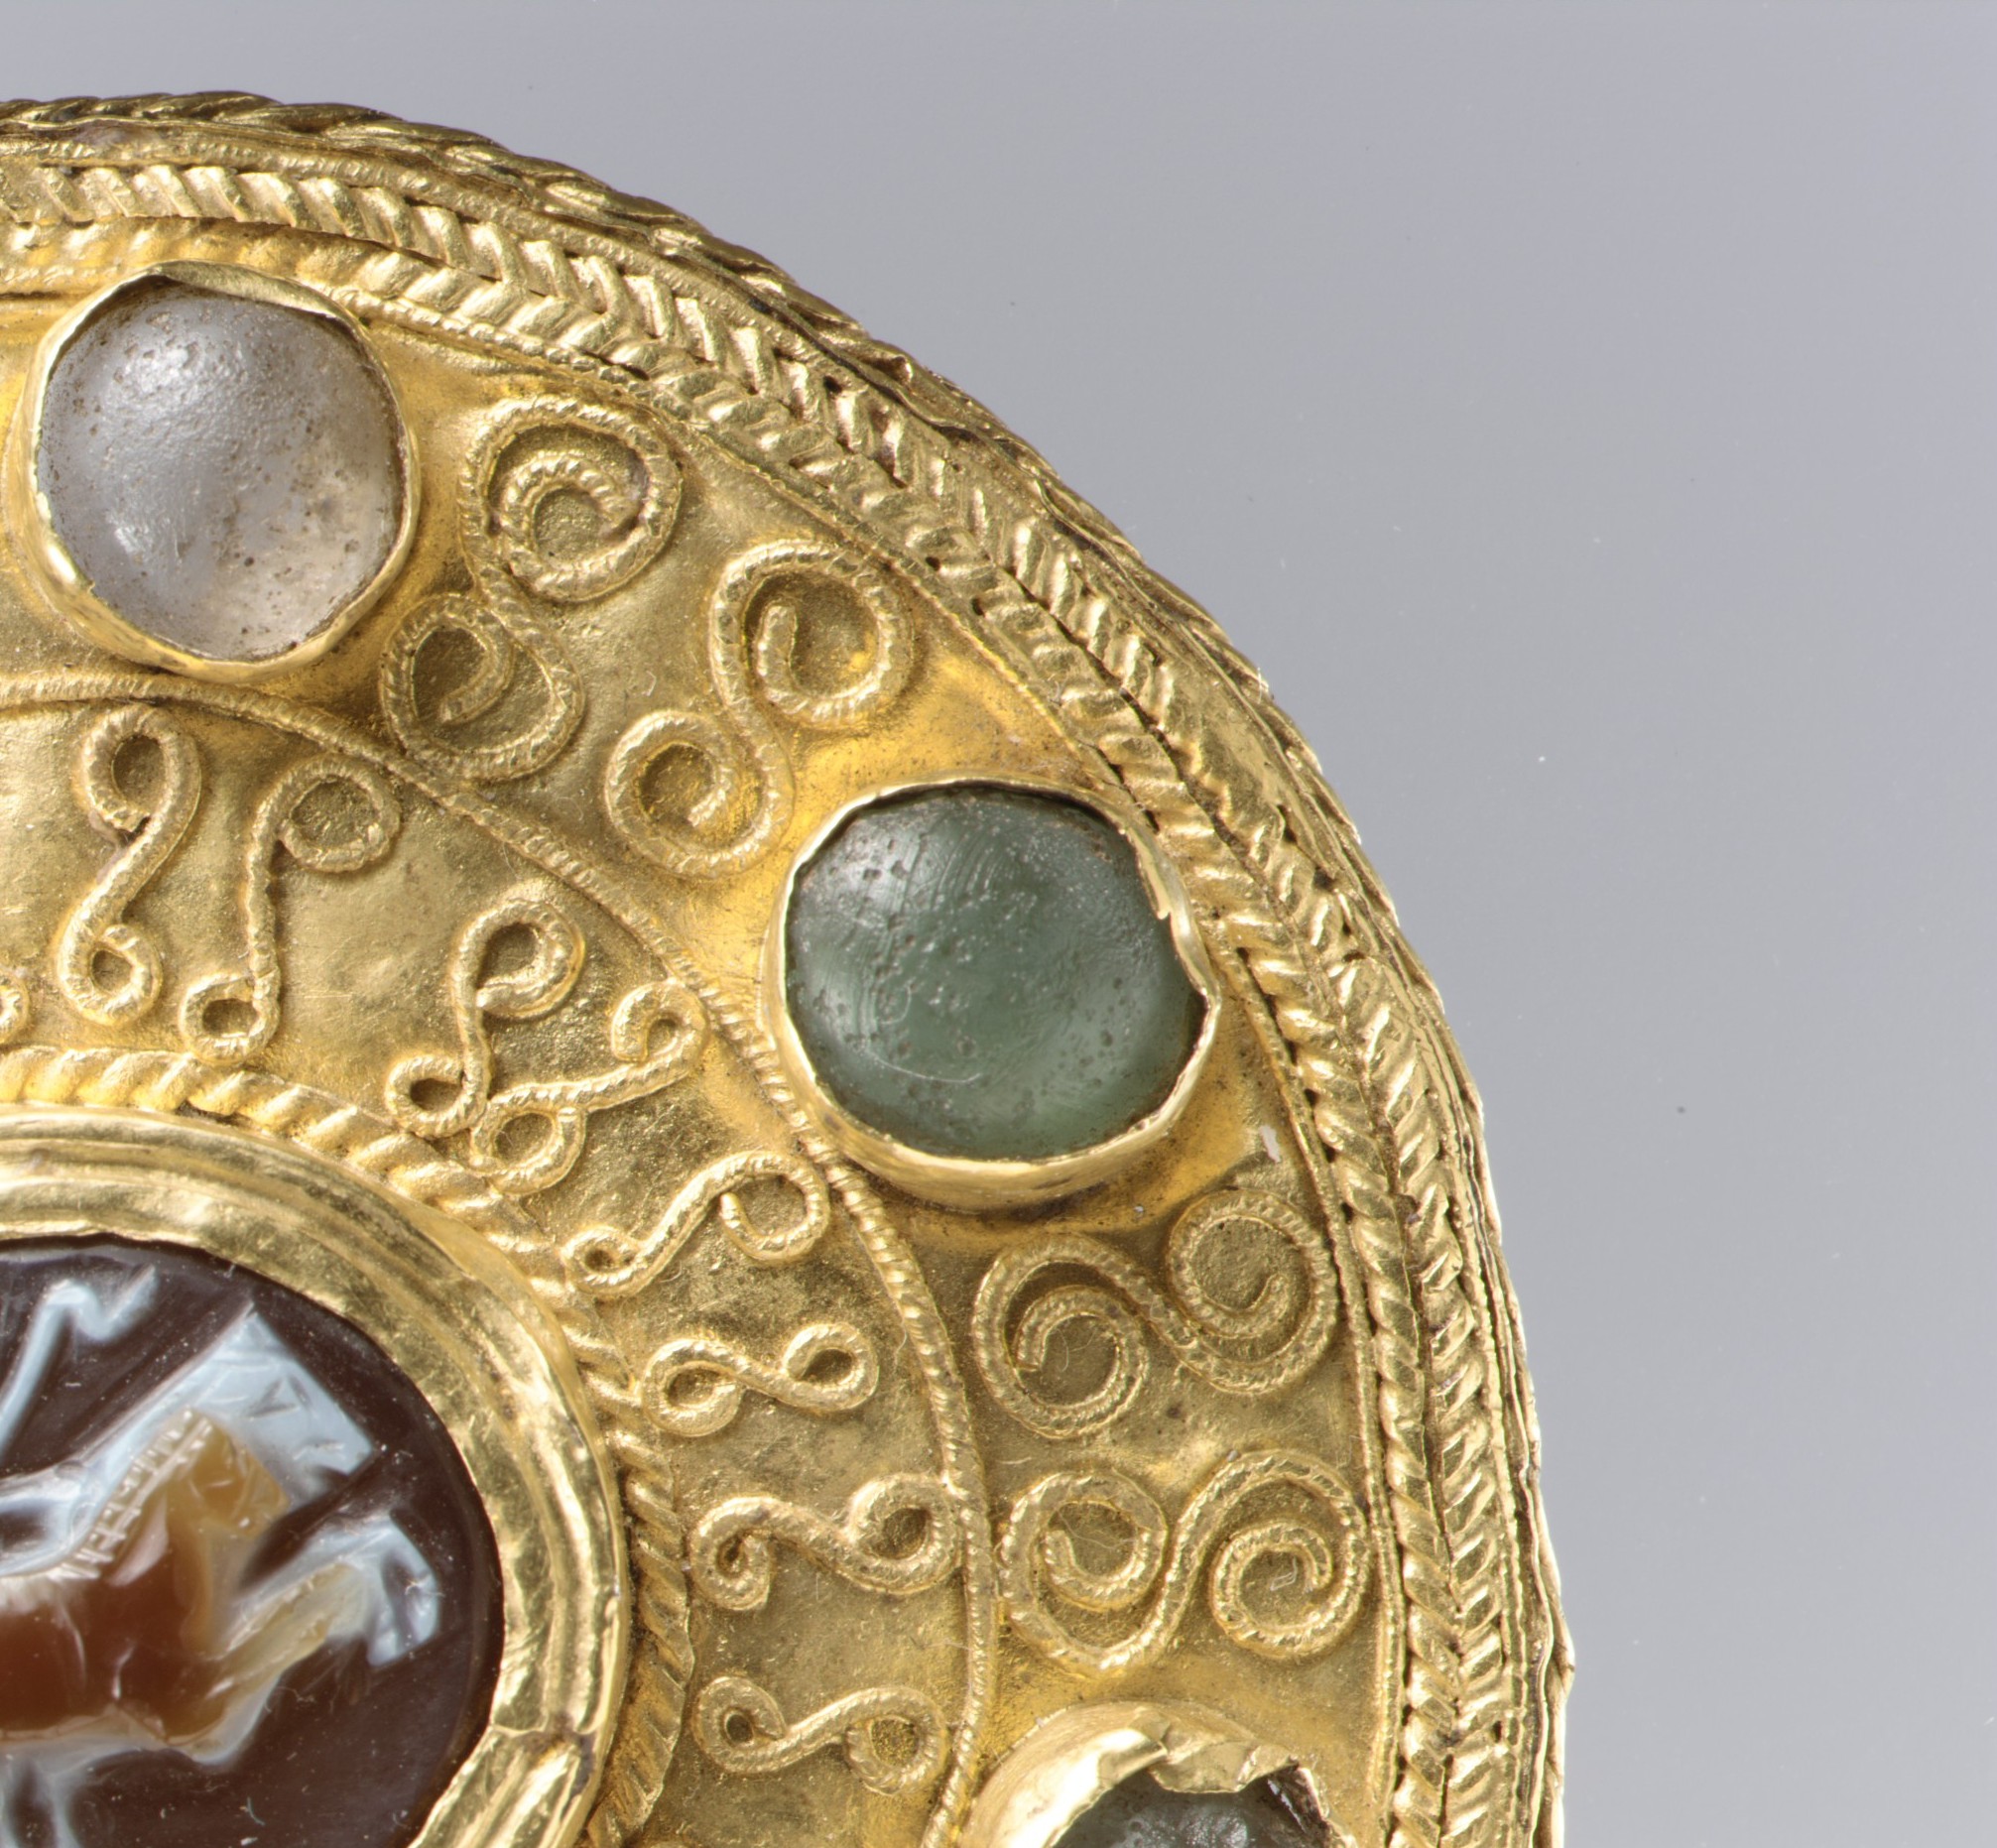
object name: ring with scarab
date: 7000 BCE-330 CE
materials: gemstone, gold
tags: scarabs